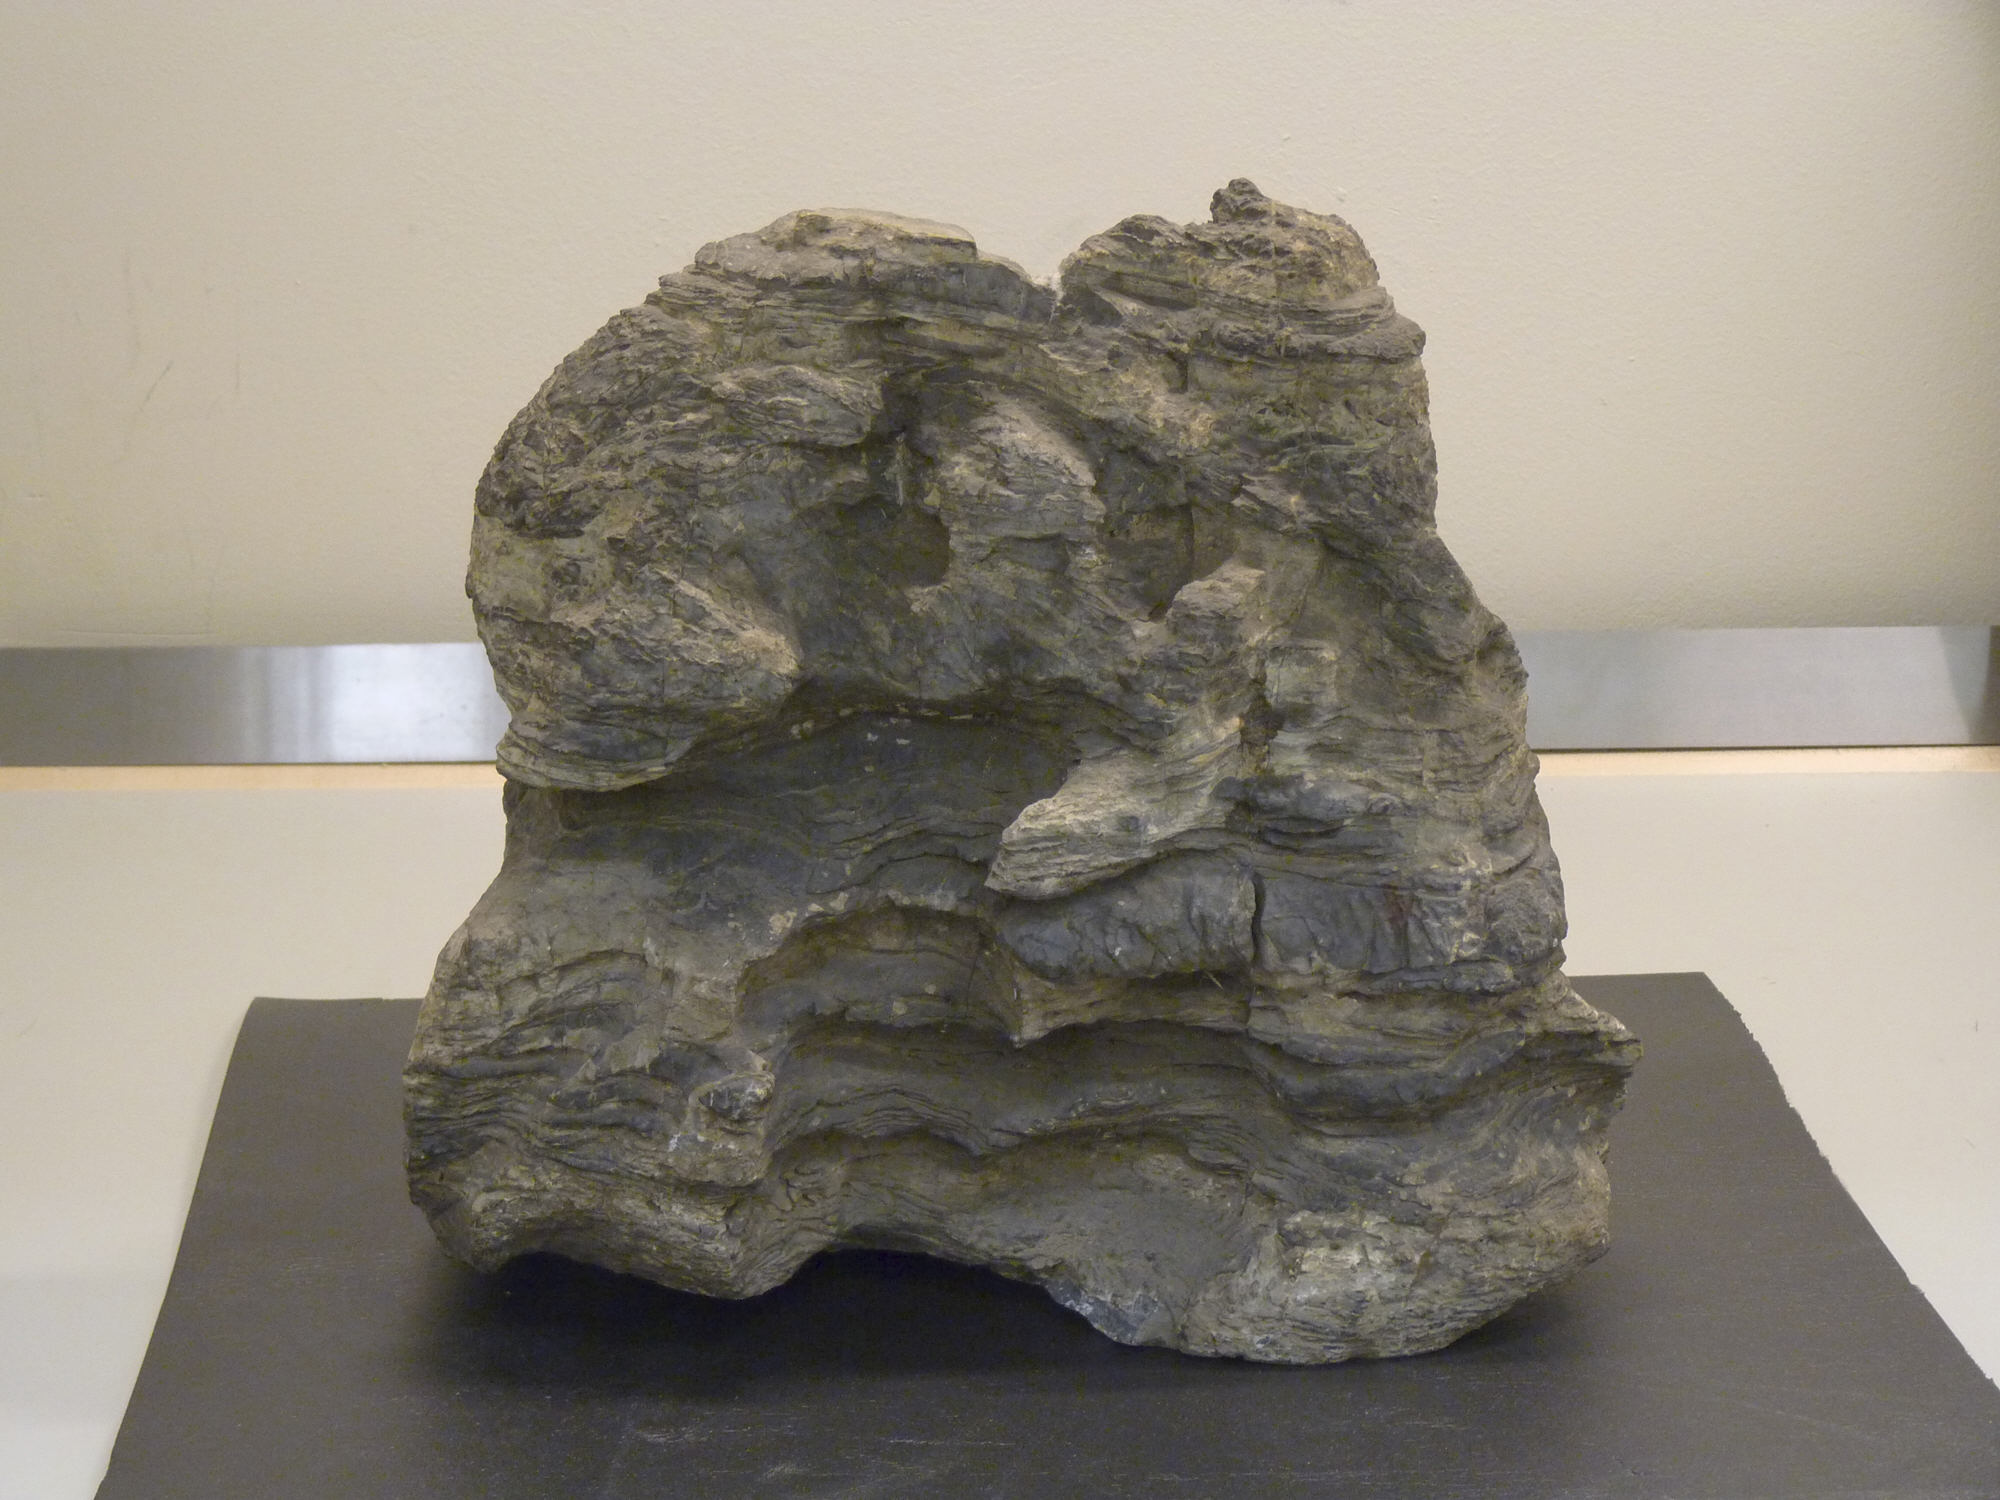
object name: scholar's rock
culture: chinese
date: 1701-2000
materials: limestone, wood